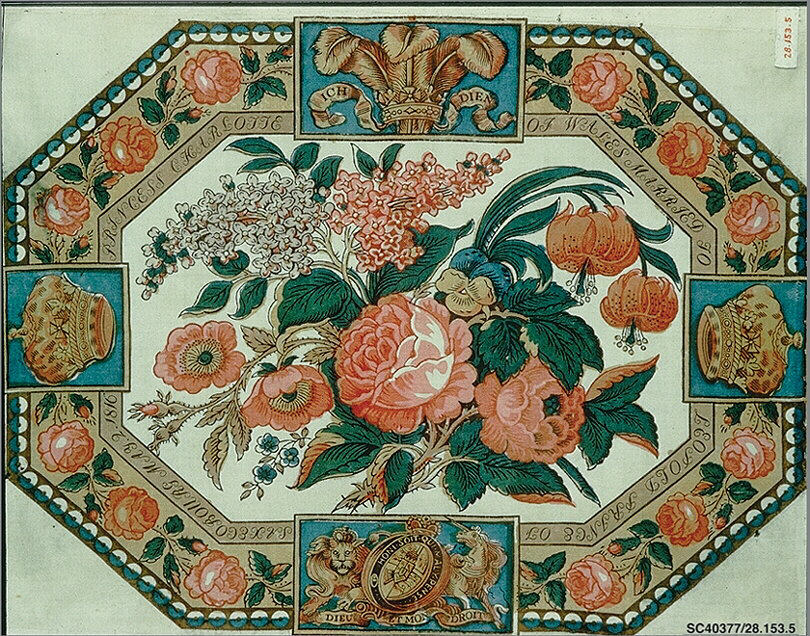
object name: panel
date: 1816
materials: cotton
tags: flowers,coat of arms